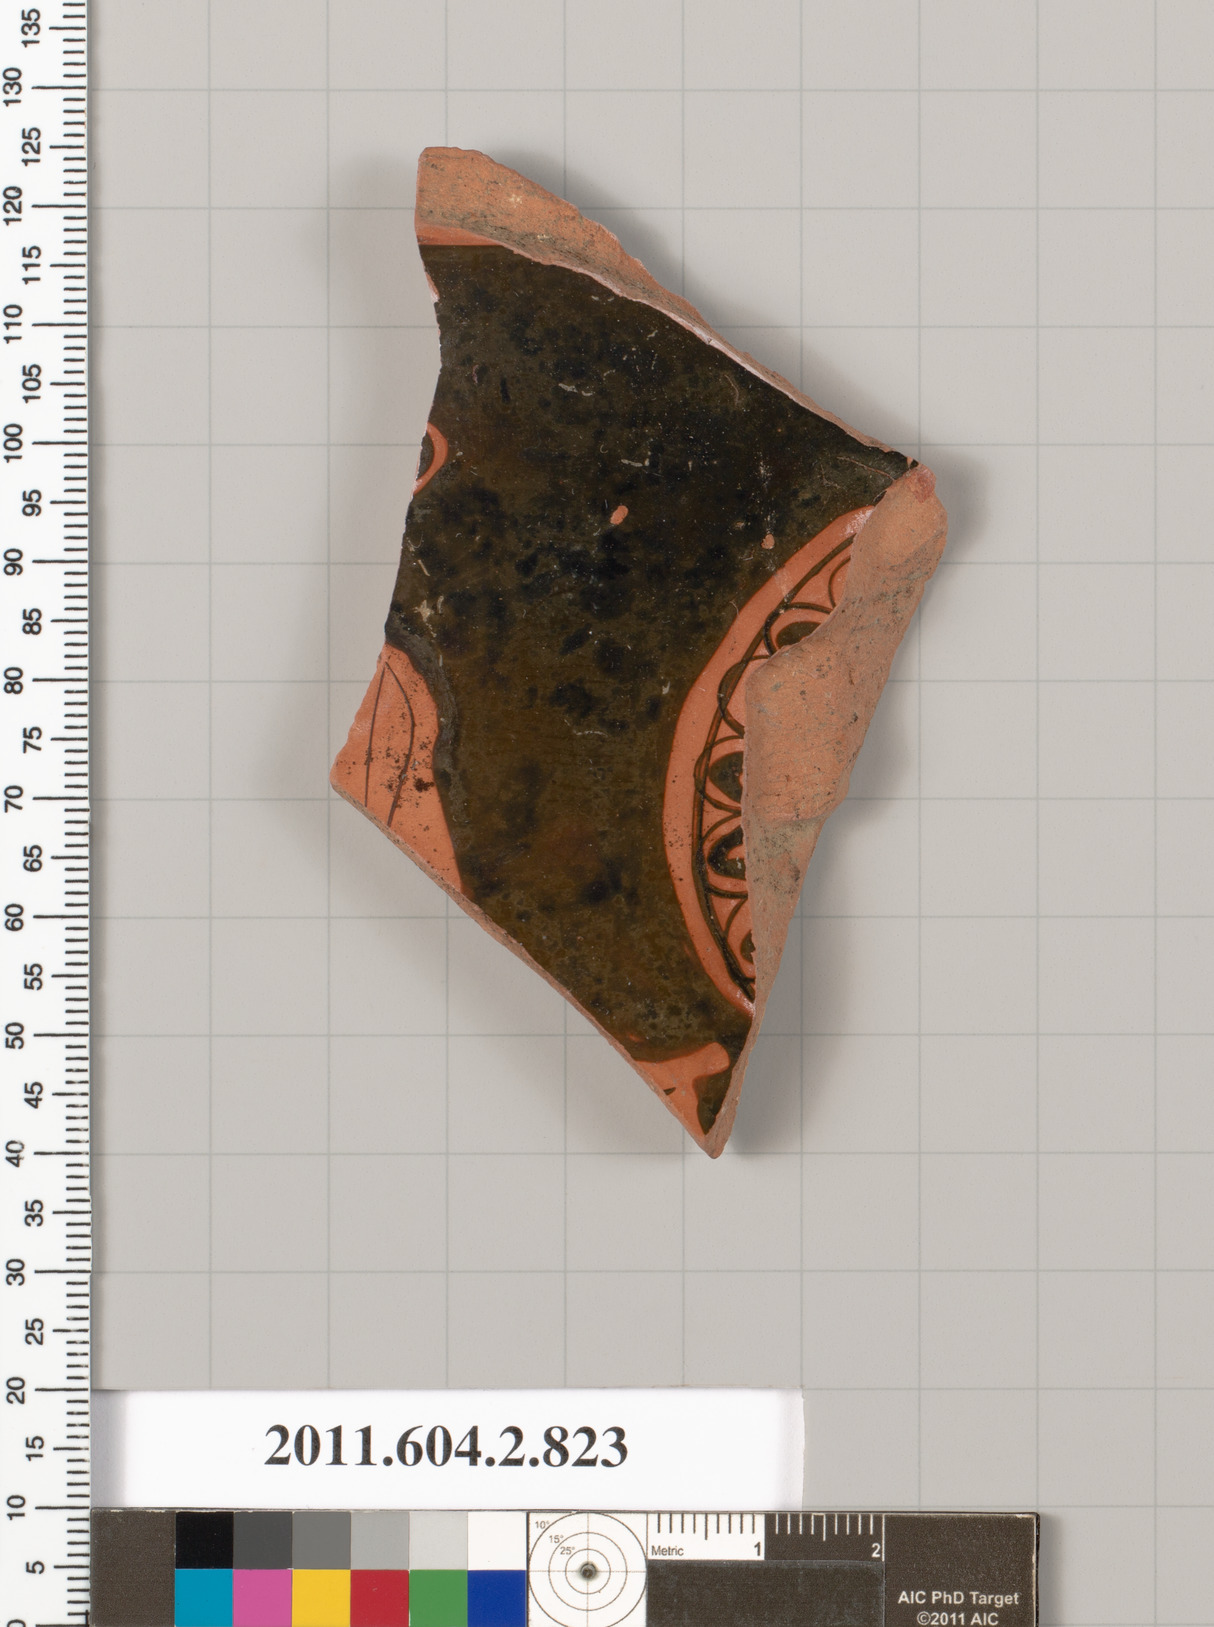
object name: bell krater fragment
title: Terracotta fragment of a bell-krater (bowl for mixing wine and water)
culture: greek, attic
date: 450-426 BCE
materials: terracotta